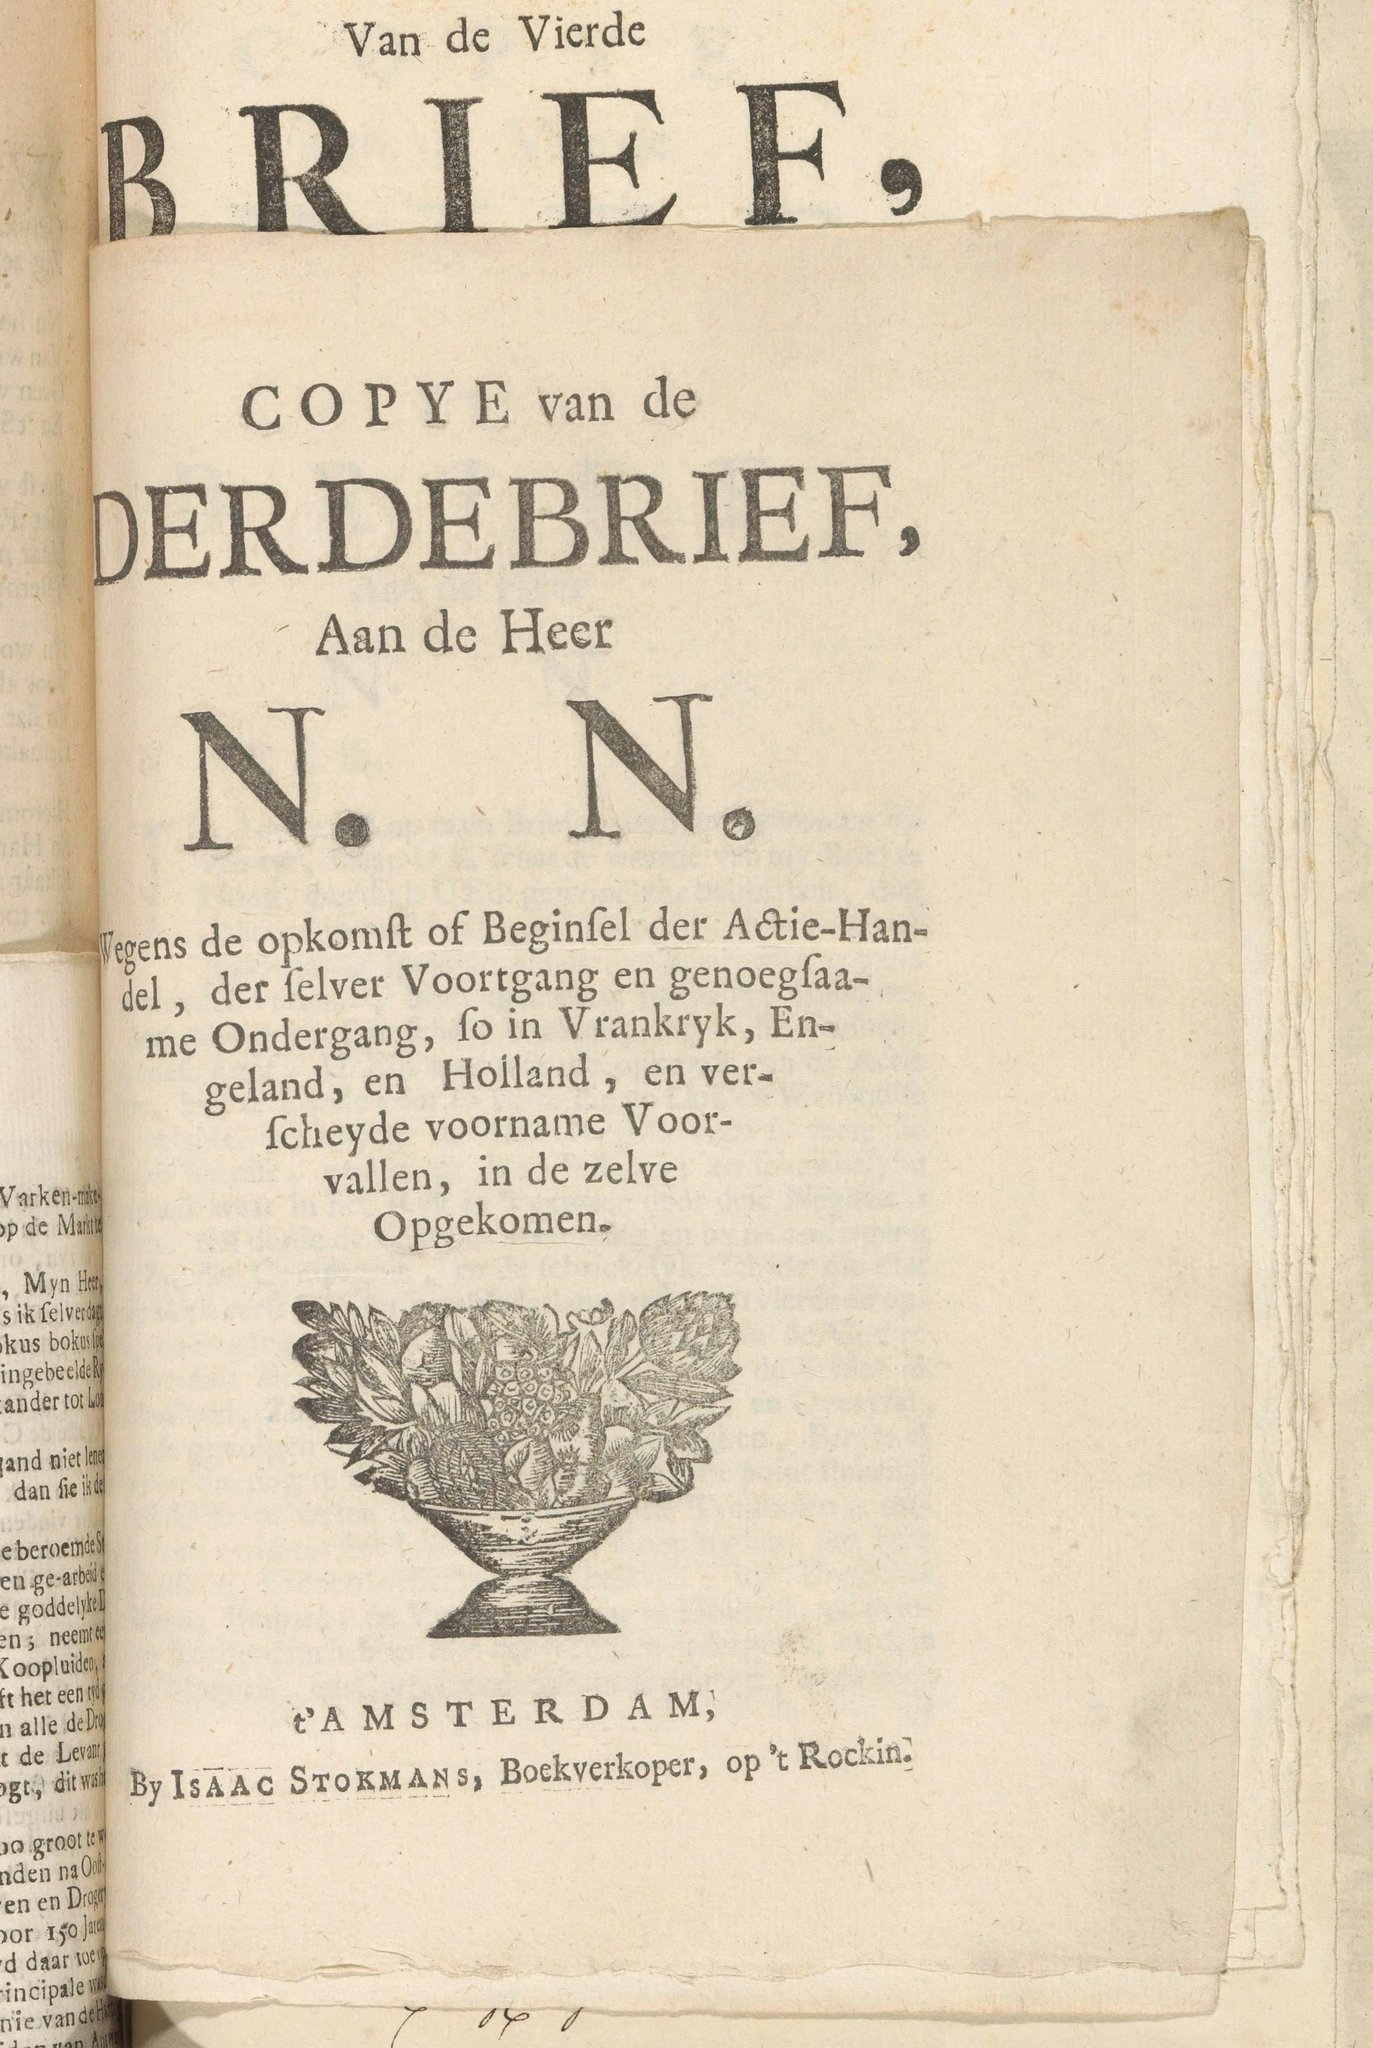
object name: pamphlet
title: Het Groote Tafereel der Dwaasheid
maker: isaac stokmans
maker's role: bookseller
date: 1720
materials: paper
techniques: letterpress printing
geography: amsterdam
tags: windhandel van 1720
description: Pamflet met een derde gedrukte brief van negen bladzijden waarin het bedrog van de windhandel wordt aangetoond, 1720. Pamflet meegebonden in de eerste uitgave (304 B 11) van Het Groote Tafereel der Dwaasheid met spotprenten op de Windhandel of Actiehandel van 1720.